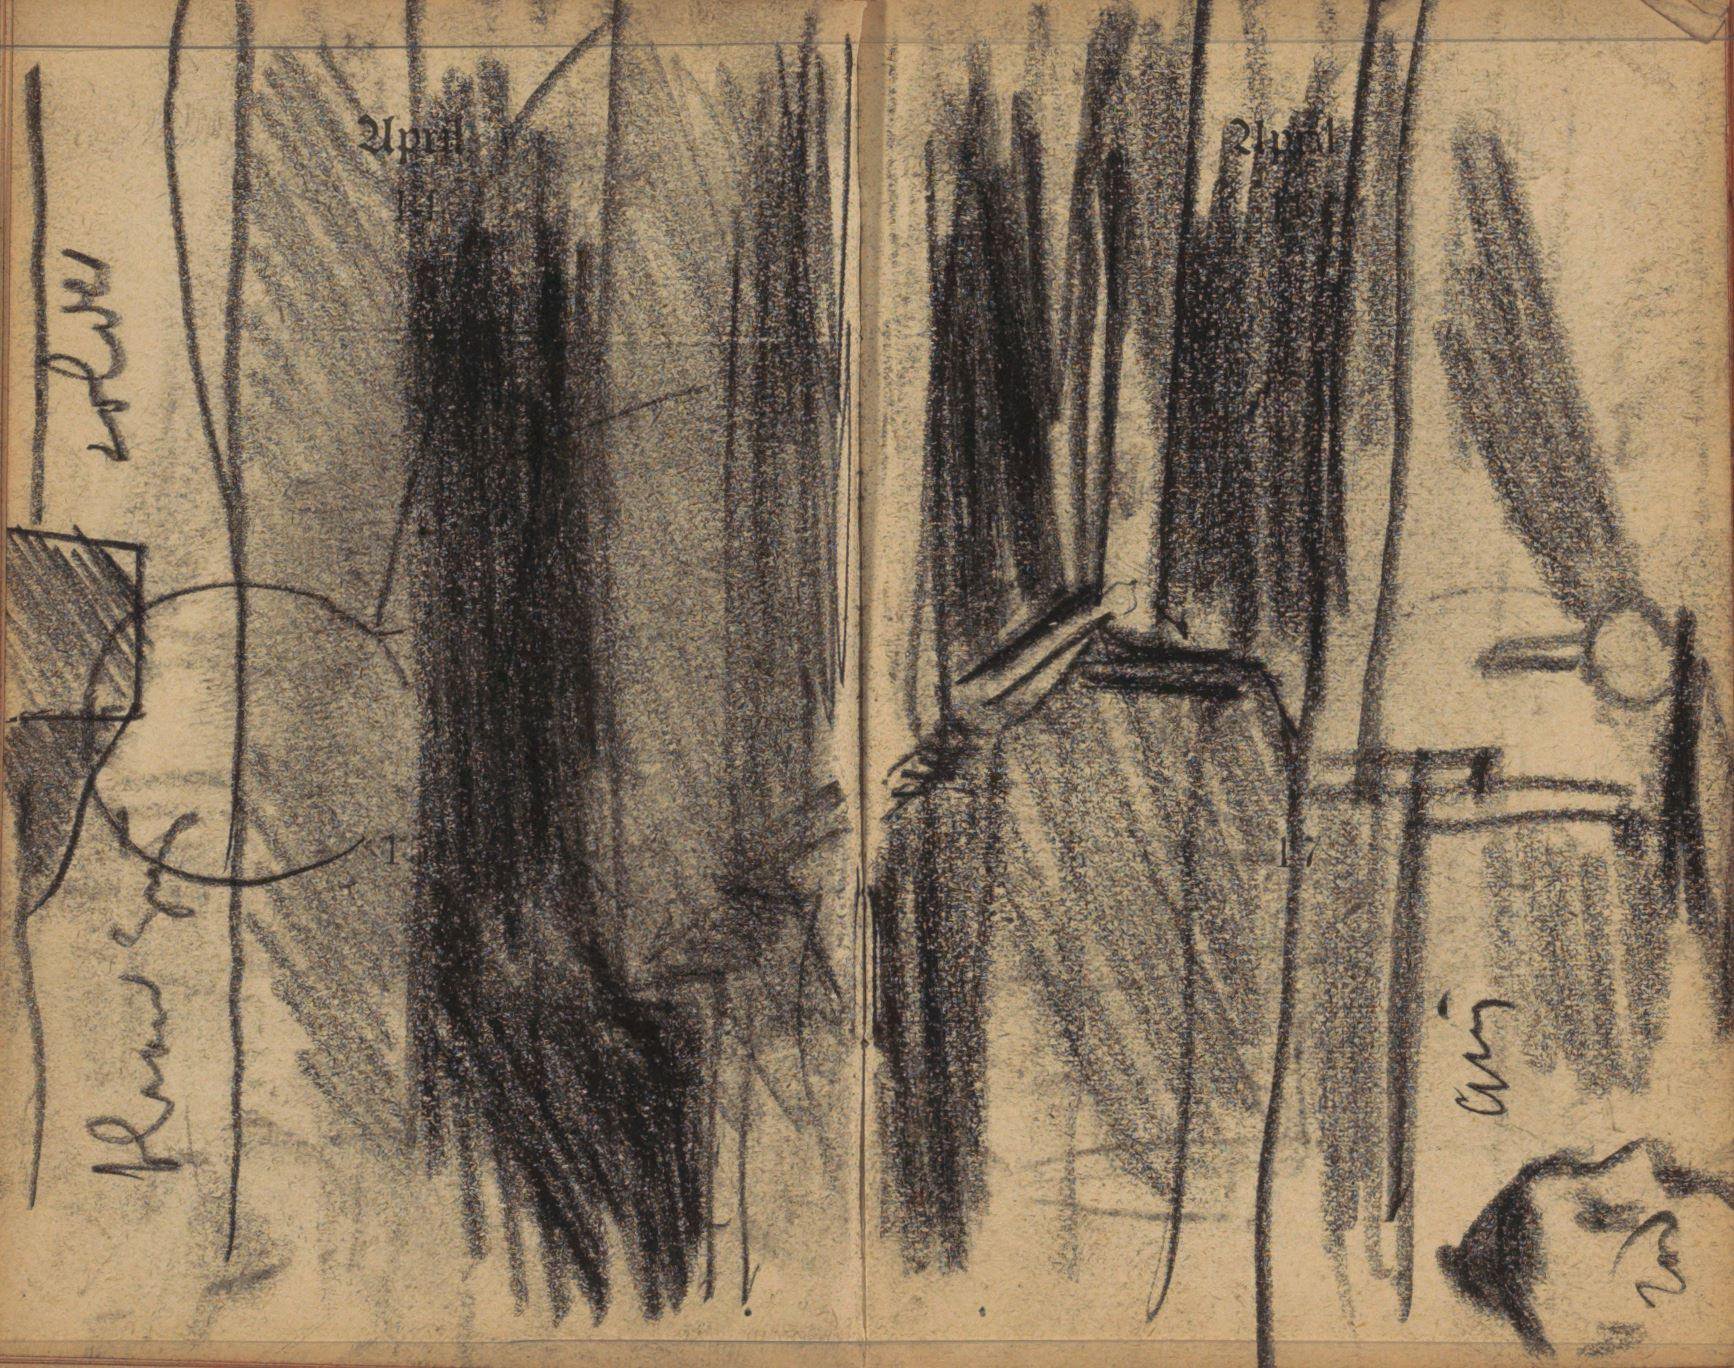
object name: sketchbook leaf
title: Architectuurstudie, mogelijk van een gebouw met een zolder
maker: george hendrik breitner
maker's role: draughtsman, painter, print maker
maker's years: 1857-1923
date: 1893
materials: chalk, paper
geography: amsterdam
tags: head (human), attic, loft, architecture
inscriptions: annotation: ‘zolder’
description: Onder het hoofd van een man. Pagina 57 en pagina 58 uit een als schetsboek gebruikte agenda met 80 bladen.